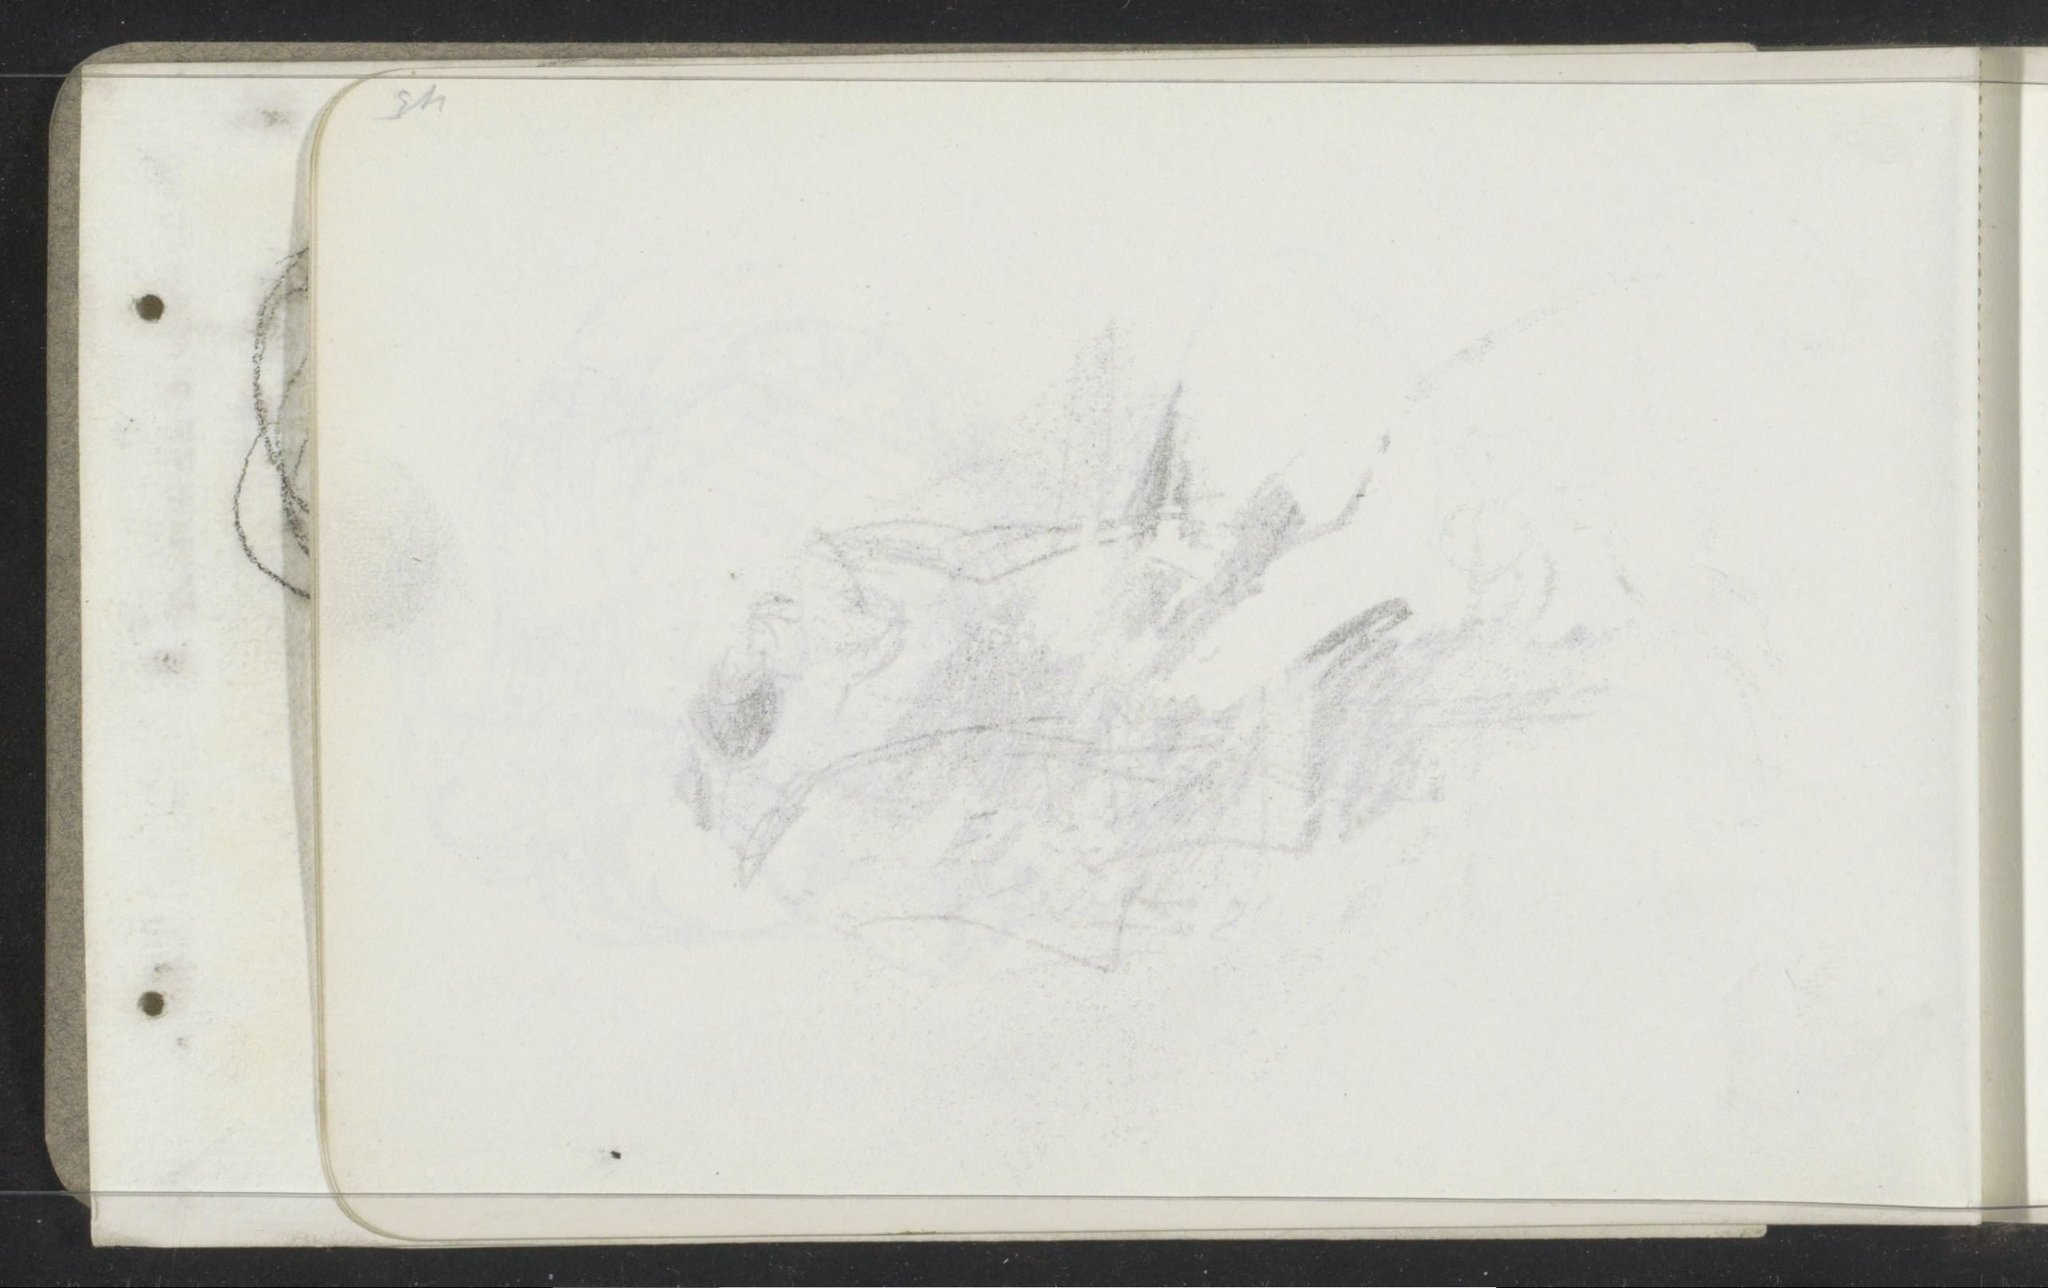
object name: sketchbook leaf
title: Abklatsch van een tekening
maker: isaac israels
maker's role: draughtsman, painter, print maker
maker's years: 1865-1934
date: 1875-1934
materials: paper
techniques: printmaking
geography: the hague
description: De originele tekening is niet meer in het schetsboek aanwezig. Blad 22 verso uit schetsboek LX met 33 bladen.